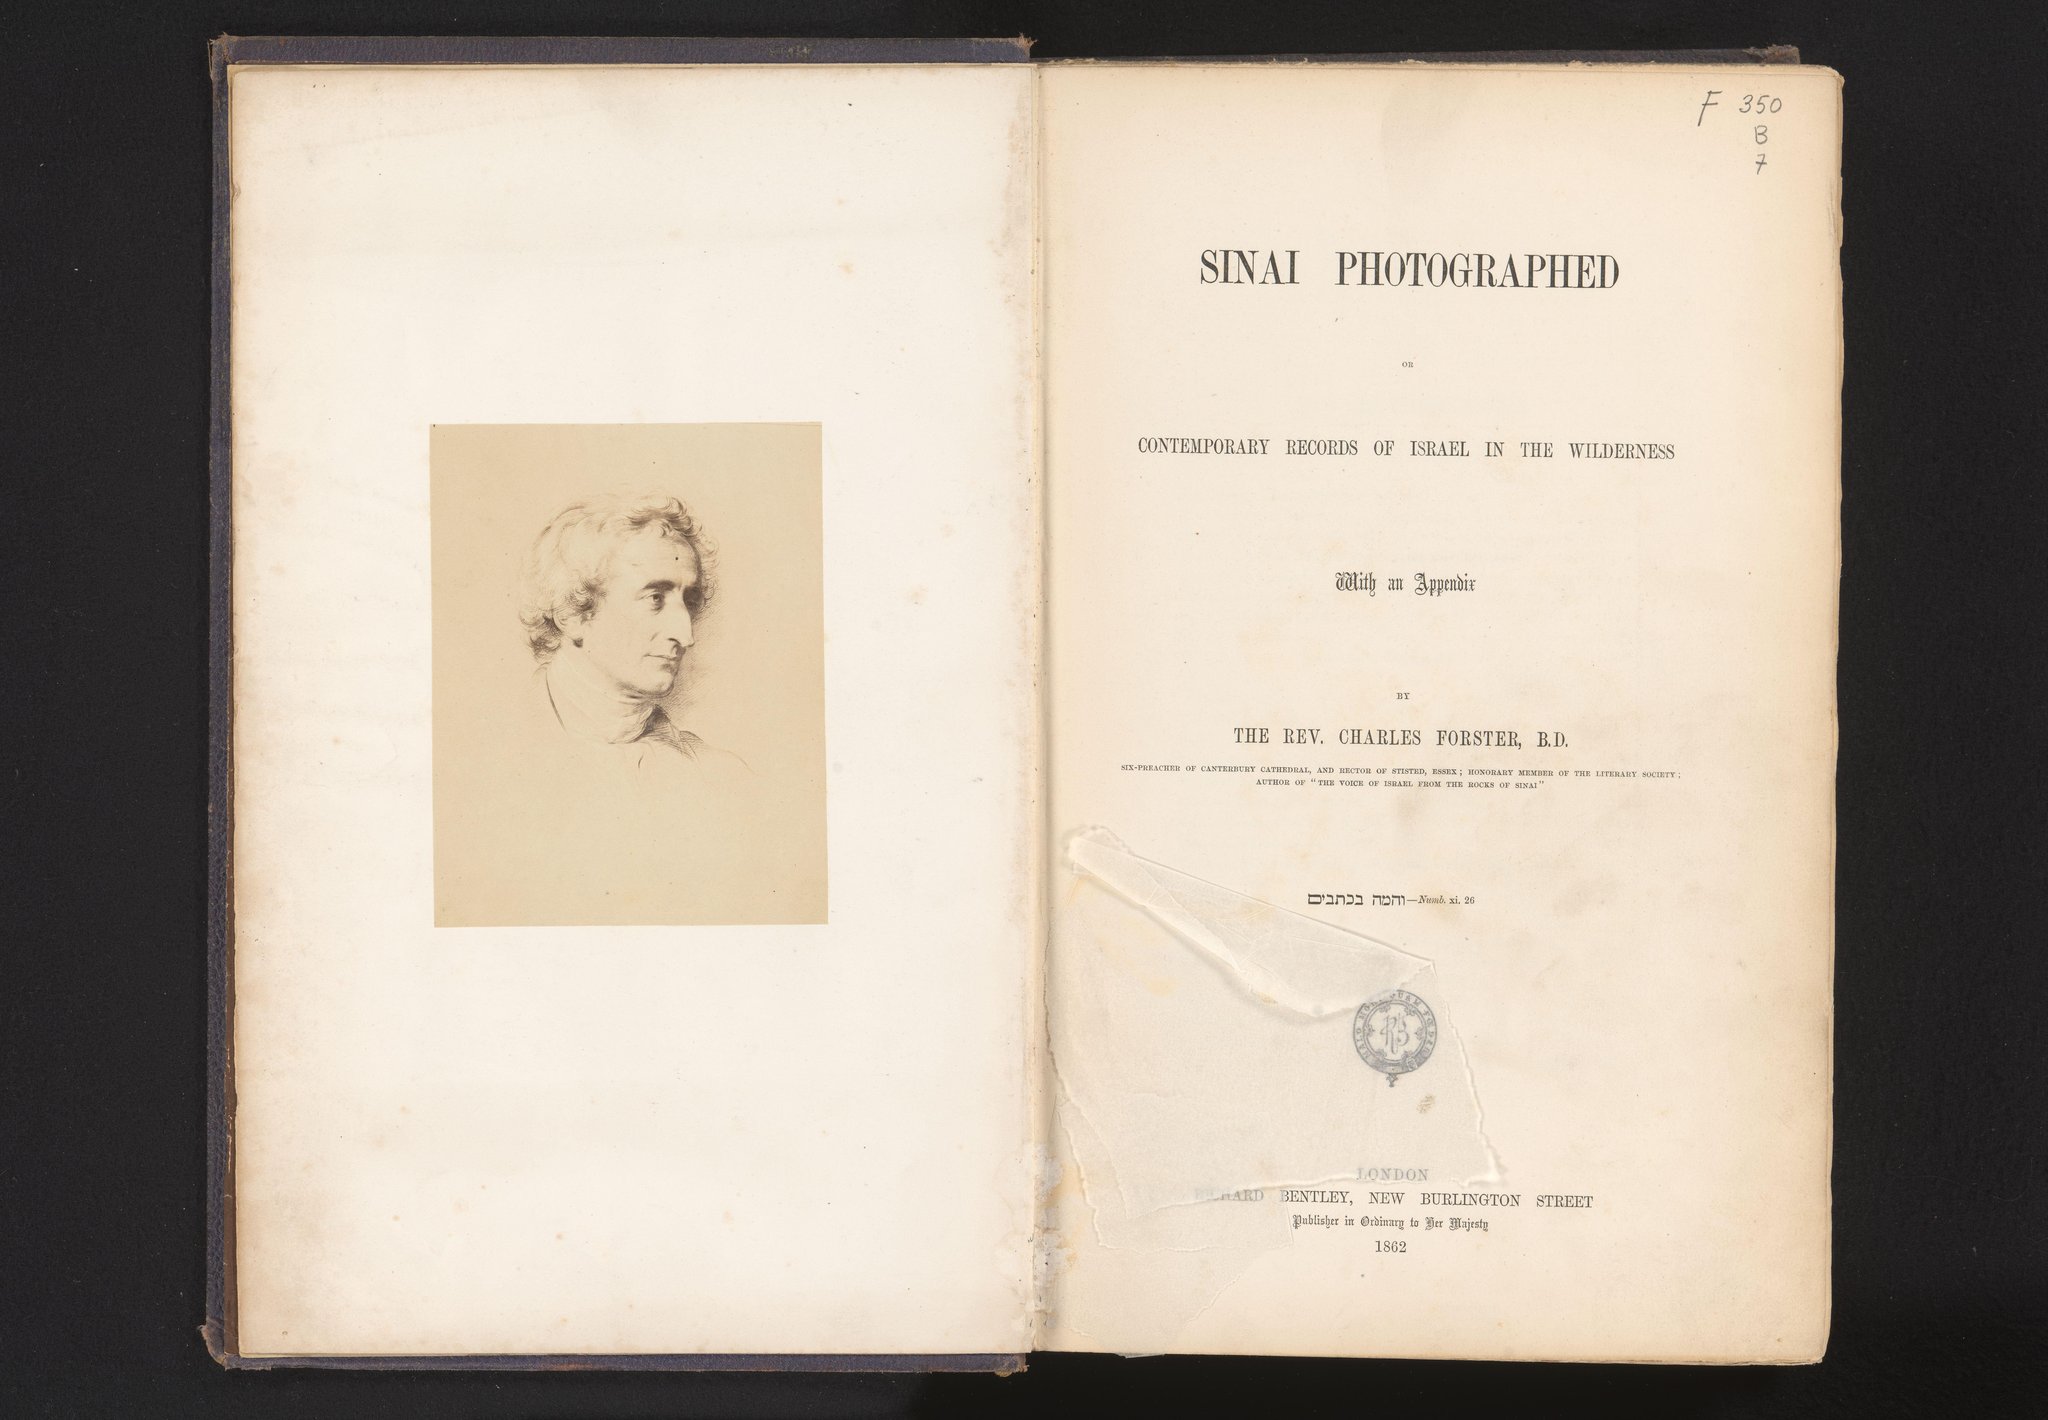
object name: photograph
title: Fotoreproductie van een getekend portret van dominee Charles Forster door George Richmond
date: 1857-1862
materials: paper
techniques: albumen print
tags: charles forster, historical persons, functionaries and dignitaries ~ protestant churches